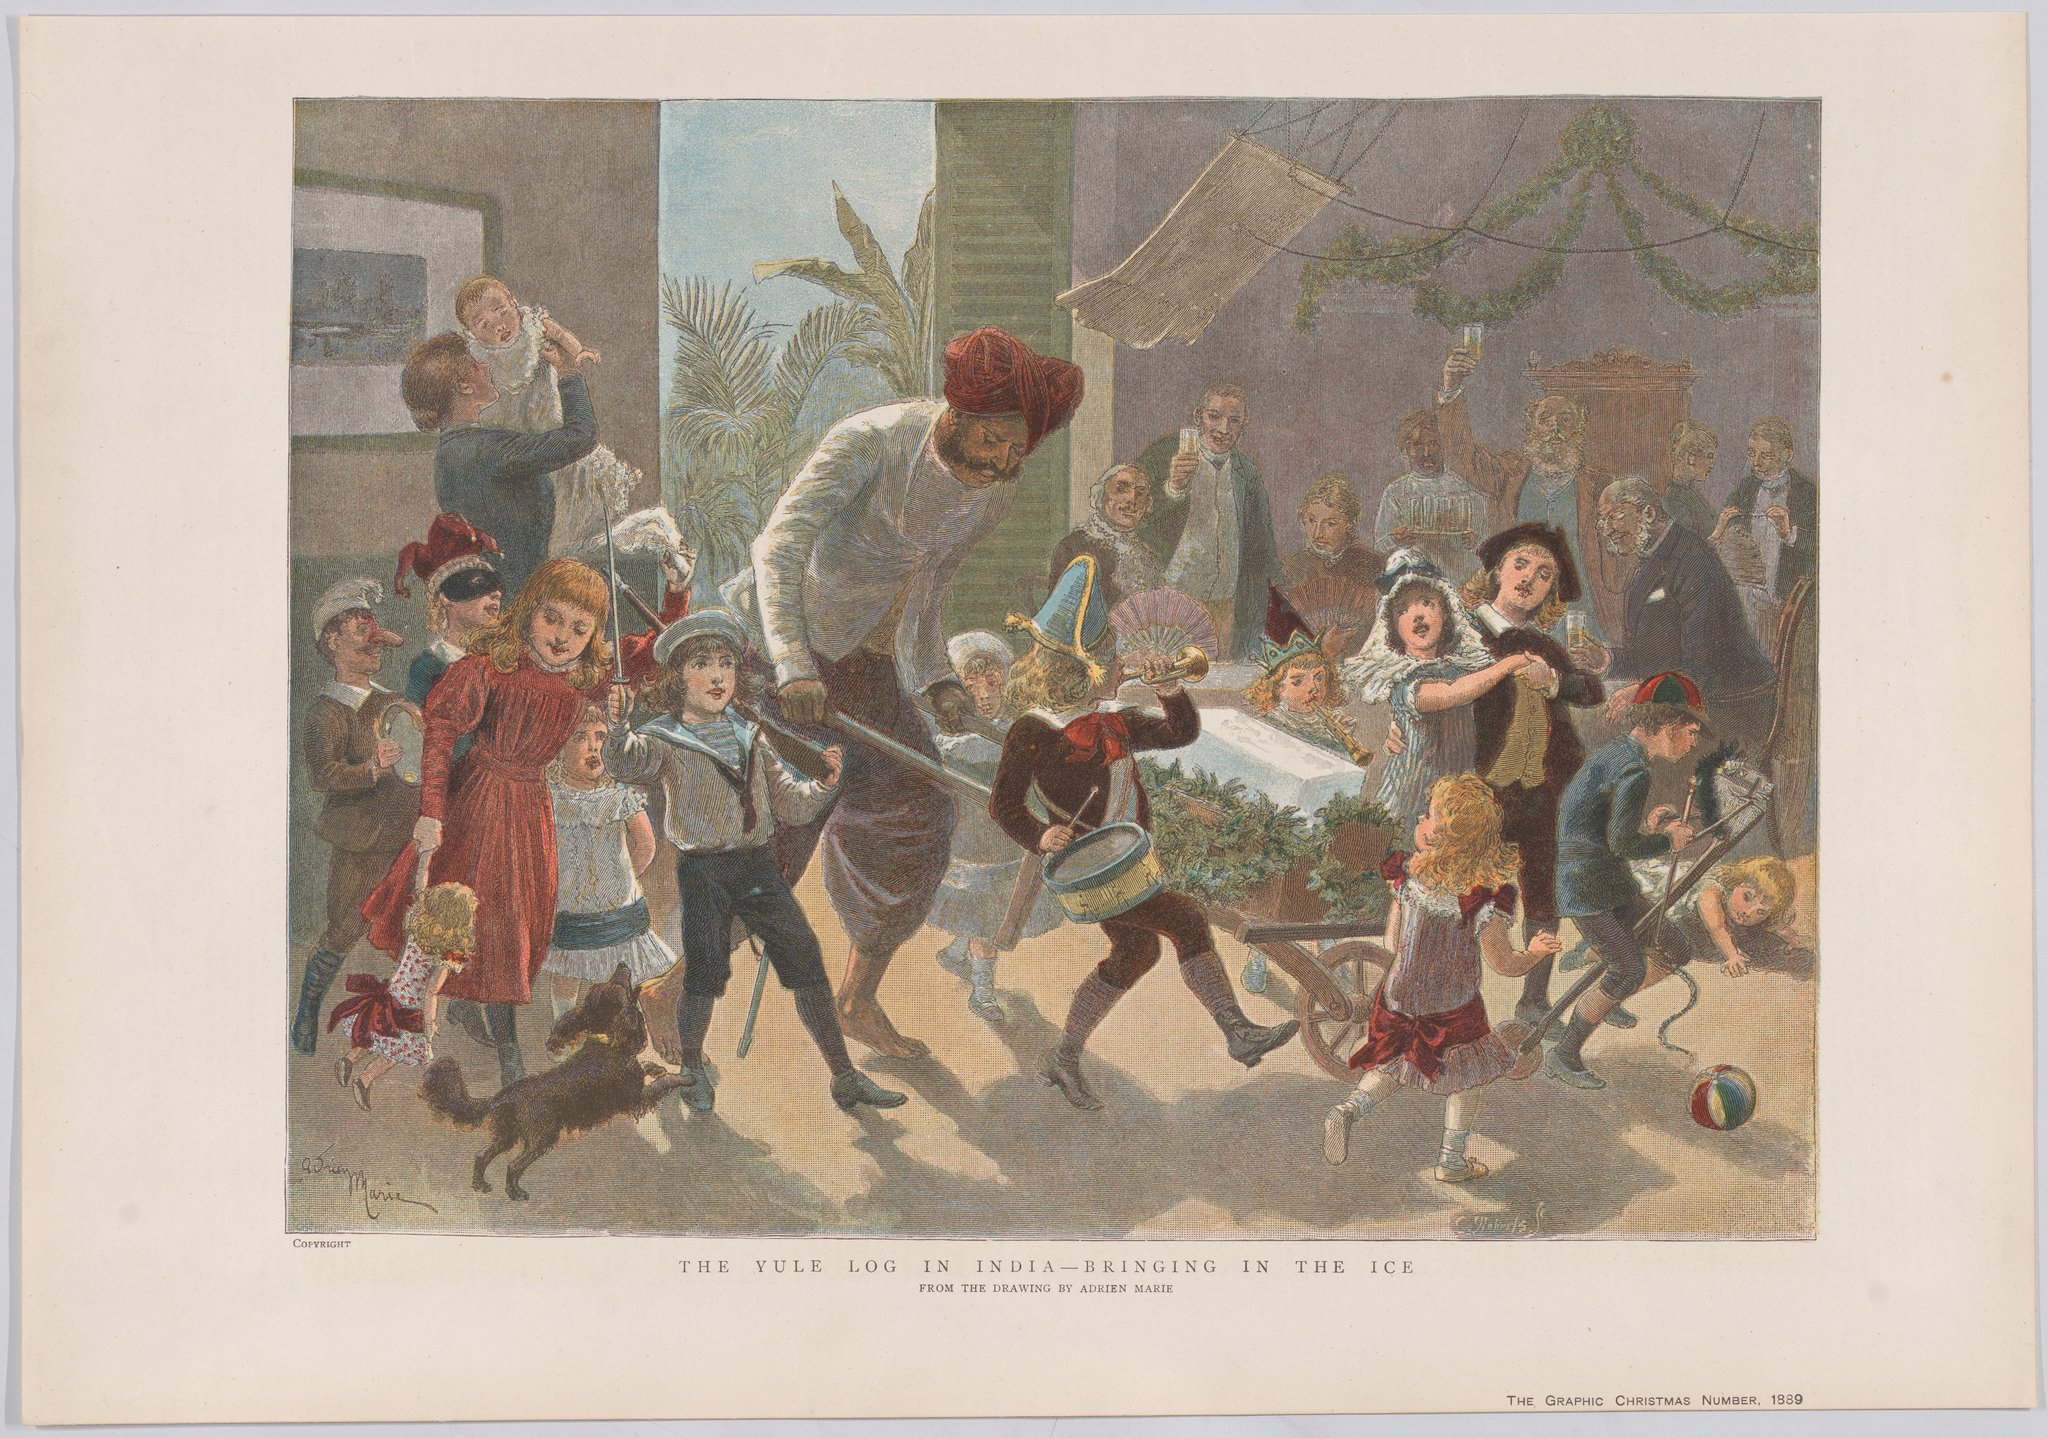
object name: print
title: The Yule Log in India — Bringing in the Ice, from "The Graphic" Christmas Number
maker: charles roberts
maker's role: engraver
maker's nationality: british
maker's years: 1870-1898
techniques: engraving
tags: boys,girls,men,women,playing,dogs,toys